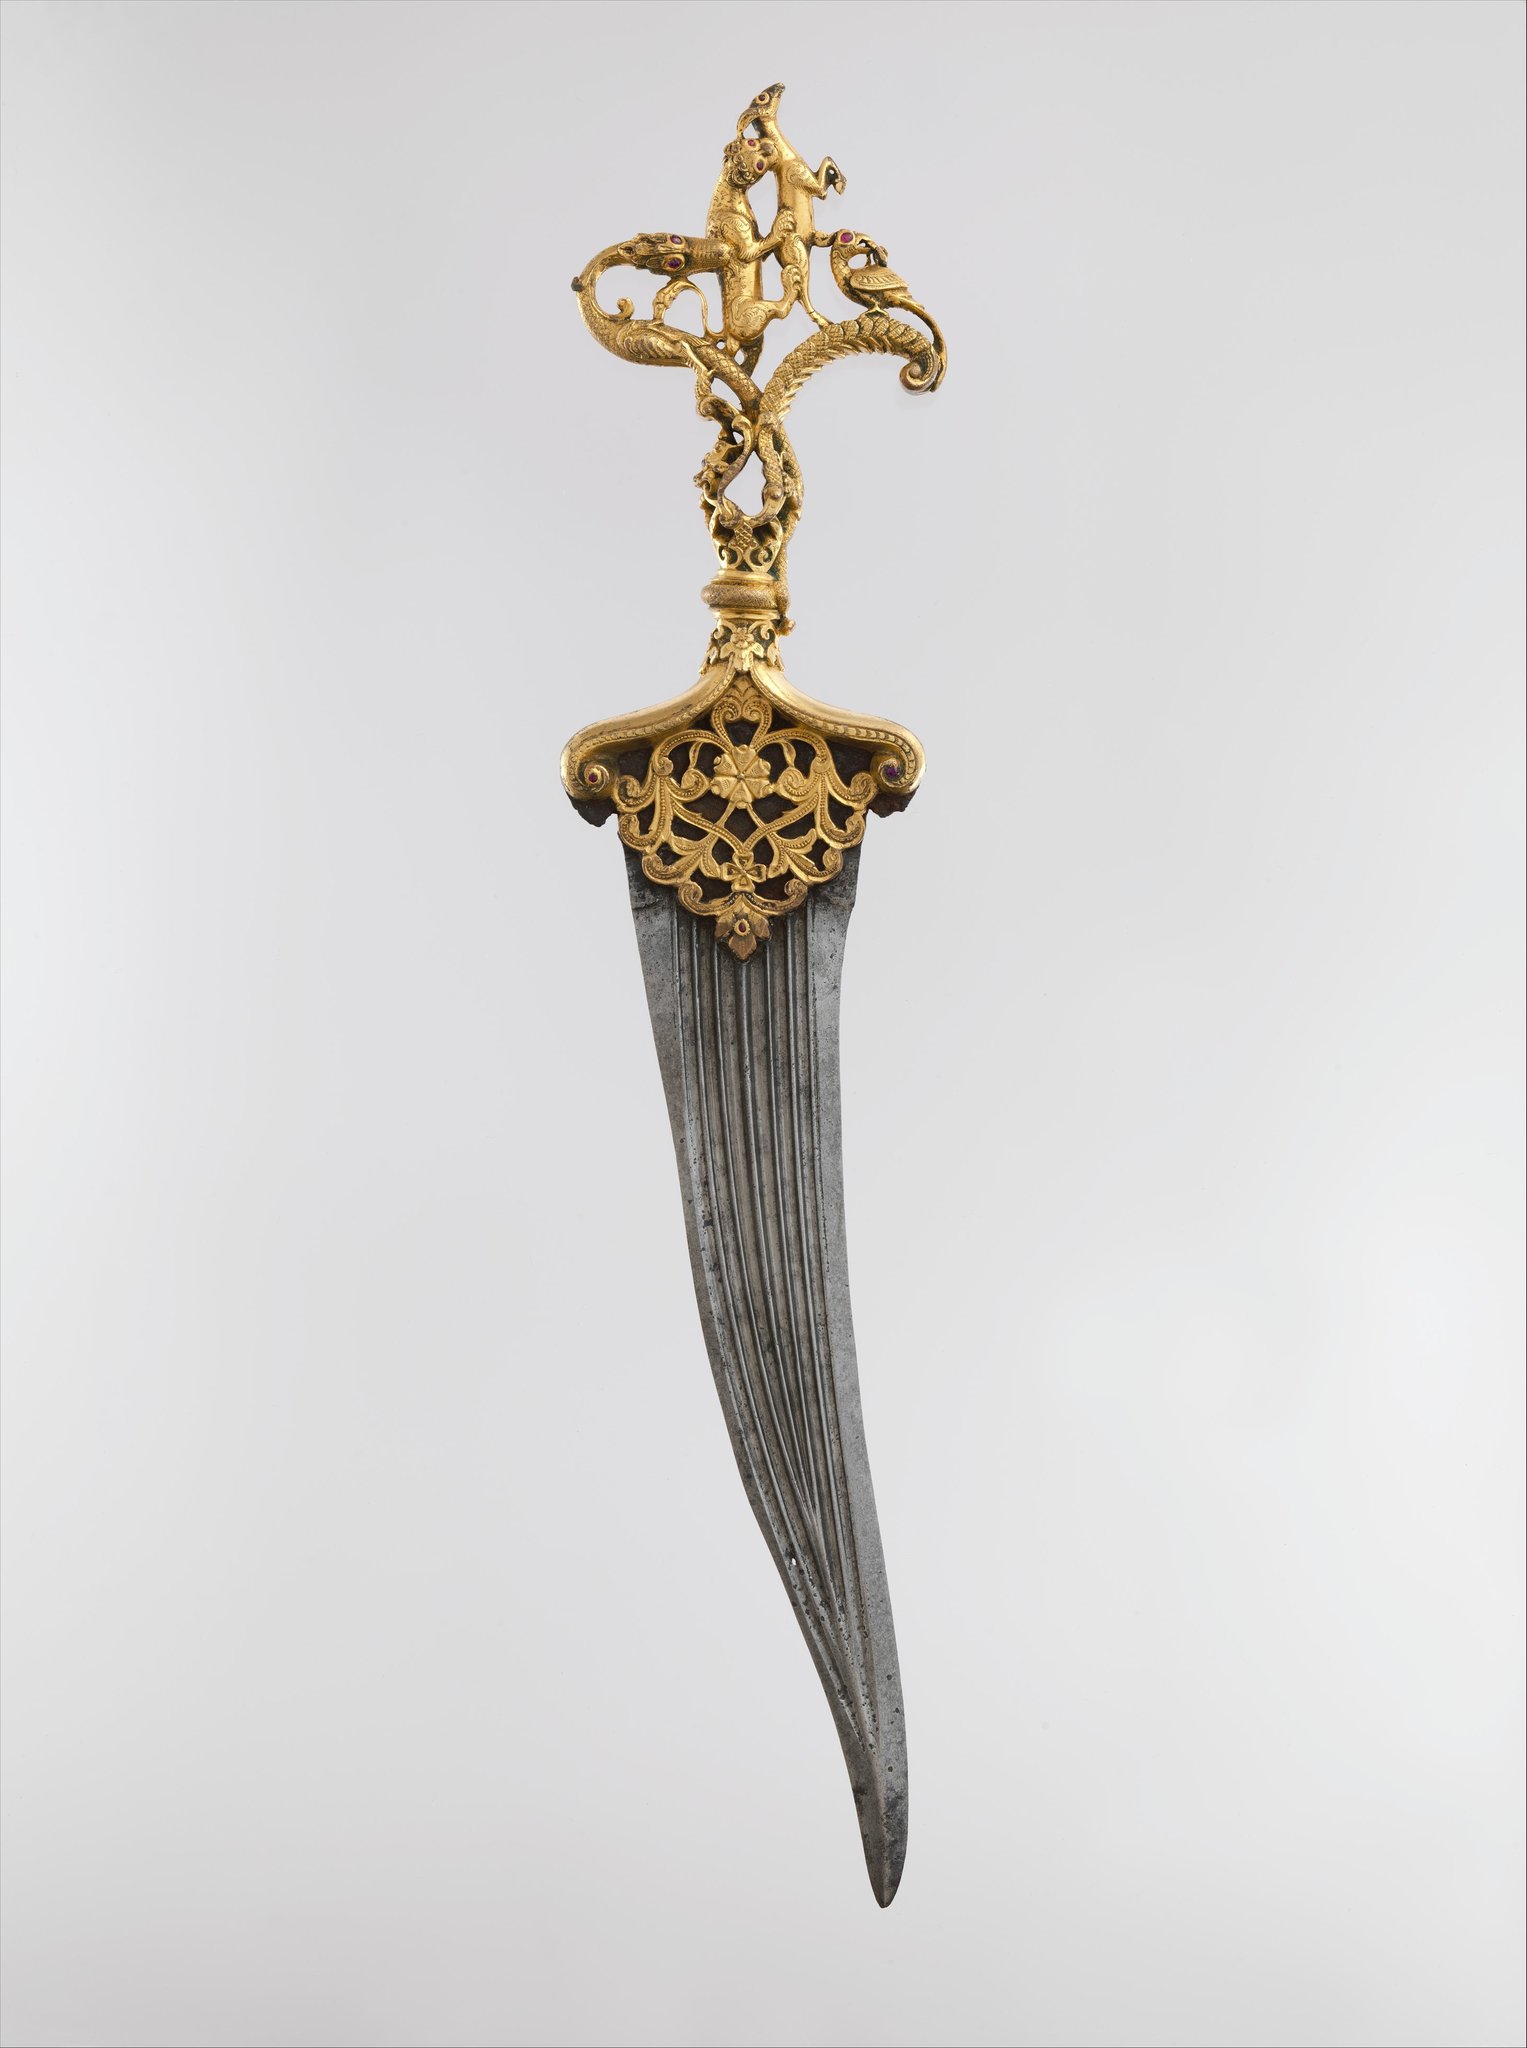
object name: dagger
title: Dagger with Zoomorphic Hilt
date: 1551-1600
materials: copper, gemstone, steel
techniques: casting, chasing, gilding, inlay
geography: india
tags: birds,dragons,deer,tigers